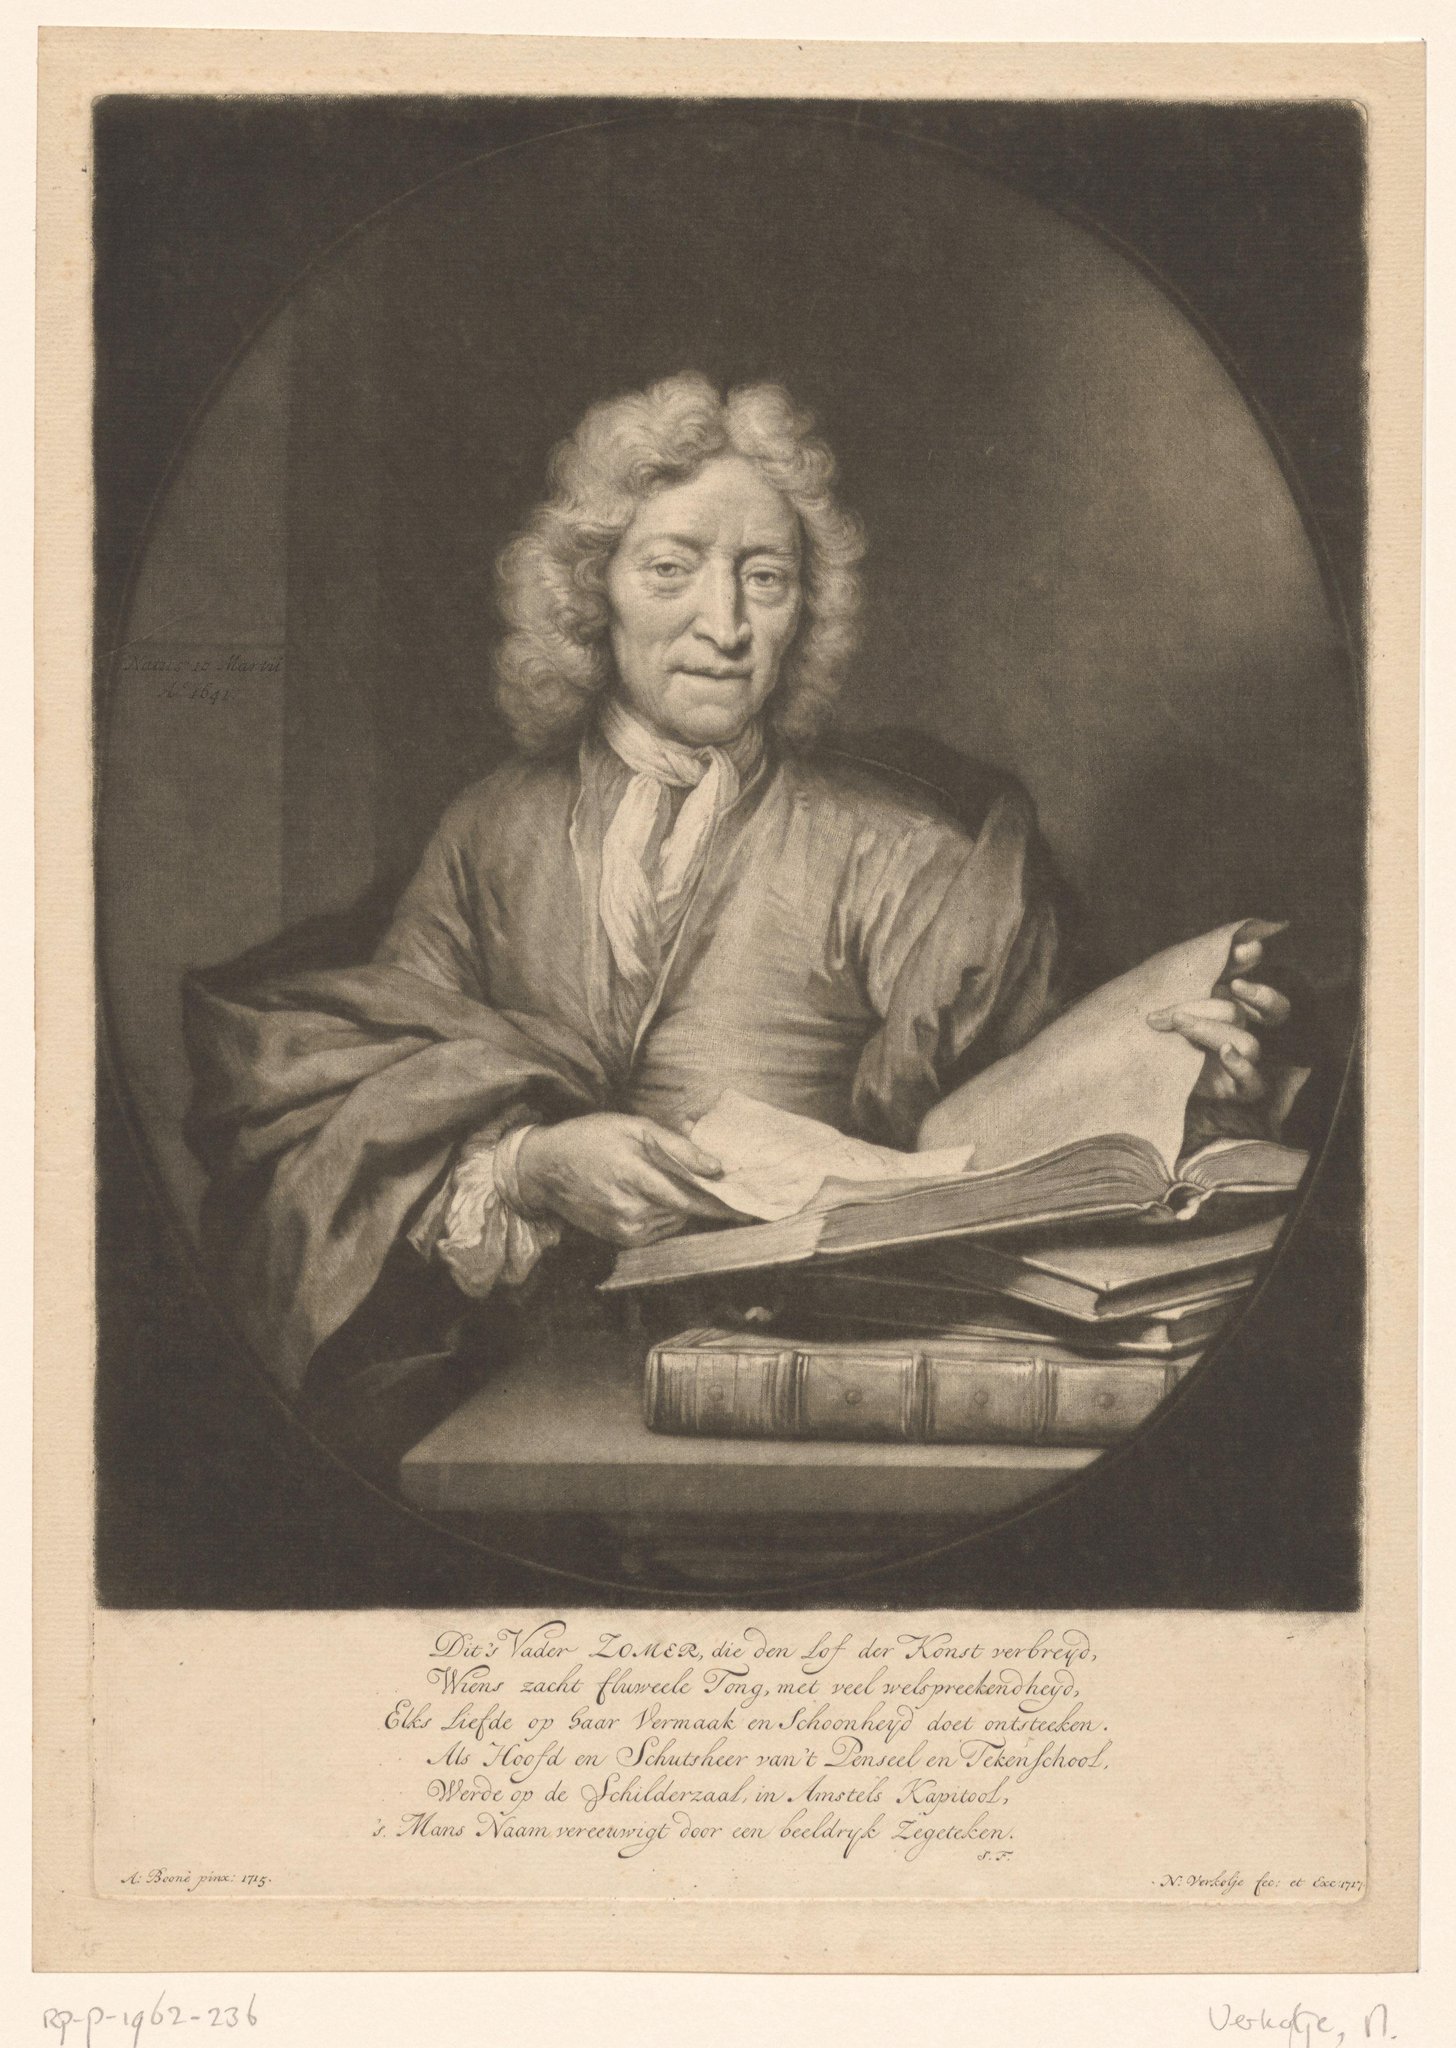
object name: print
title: Portret van Jan Pietersz. Zomer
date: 1717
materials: paper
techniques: engraving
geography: amsterdam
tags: amsterdam, draughtsman, jan pietersz. zomer, print, e.g.: engraving, etching, lithograph, historical persons, art dealer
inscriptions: date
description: De kunsthandelaar Jan Pietersz. Zomer zit aan een tafel en toont een afbeelding in een opengeslagen album. Onder het portret zes regels Nederlandse tekst; een lofdicht op zijn welbespraaktheid en kwaliteiten als kunsthandelaar.